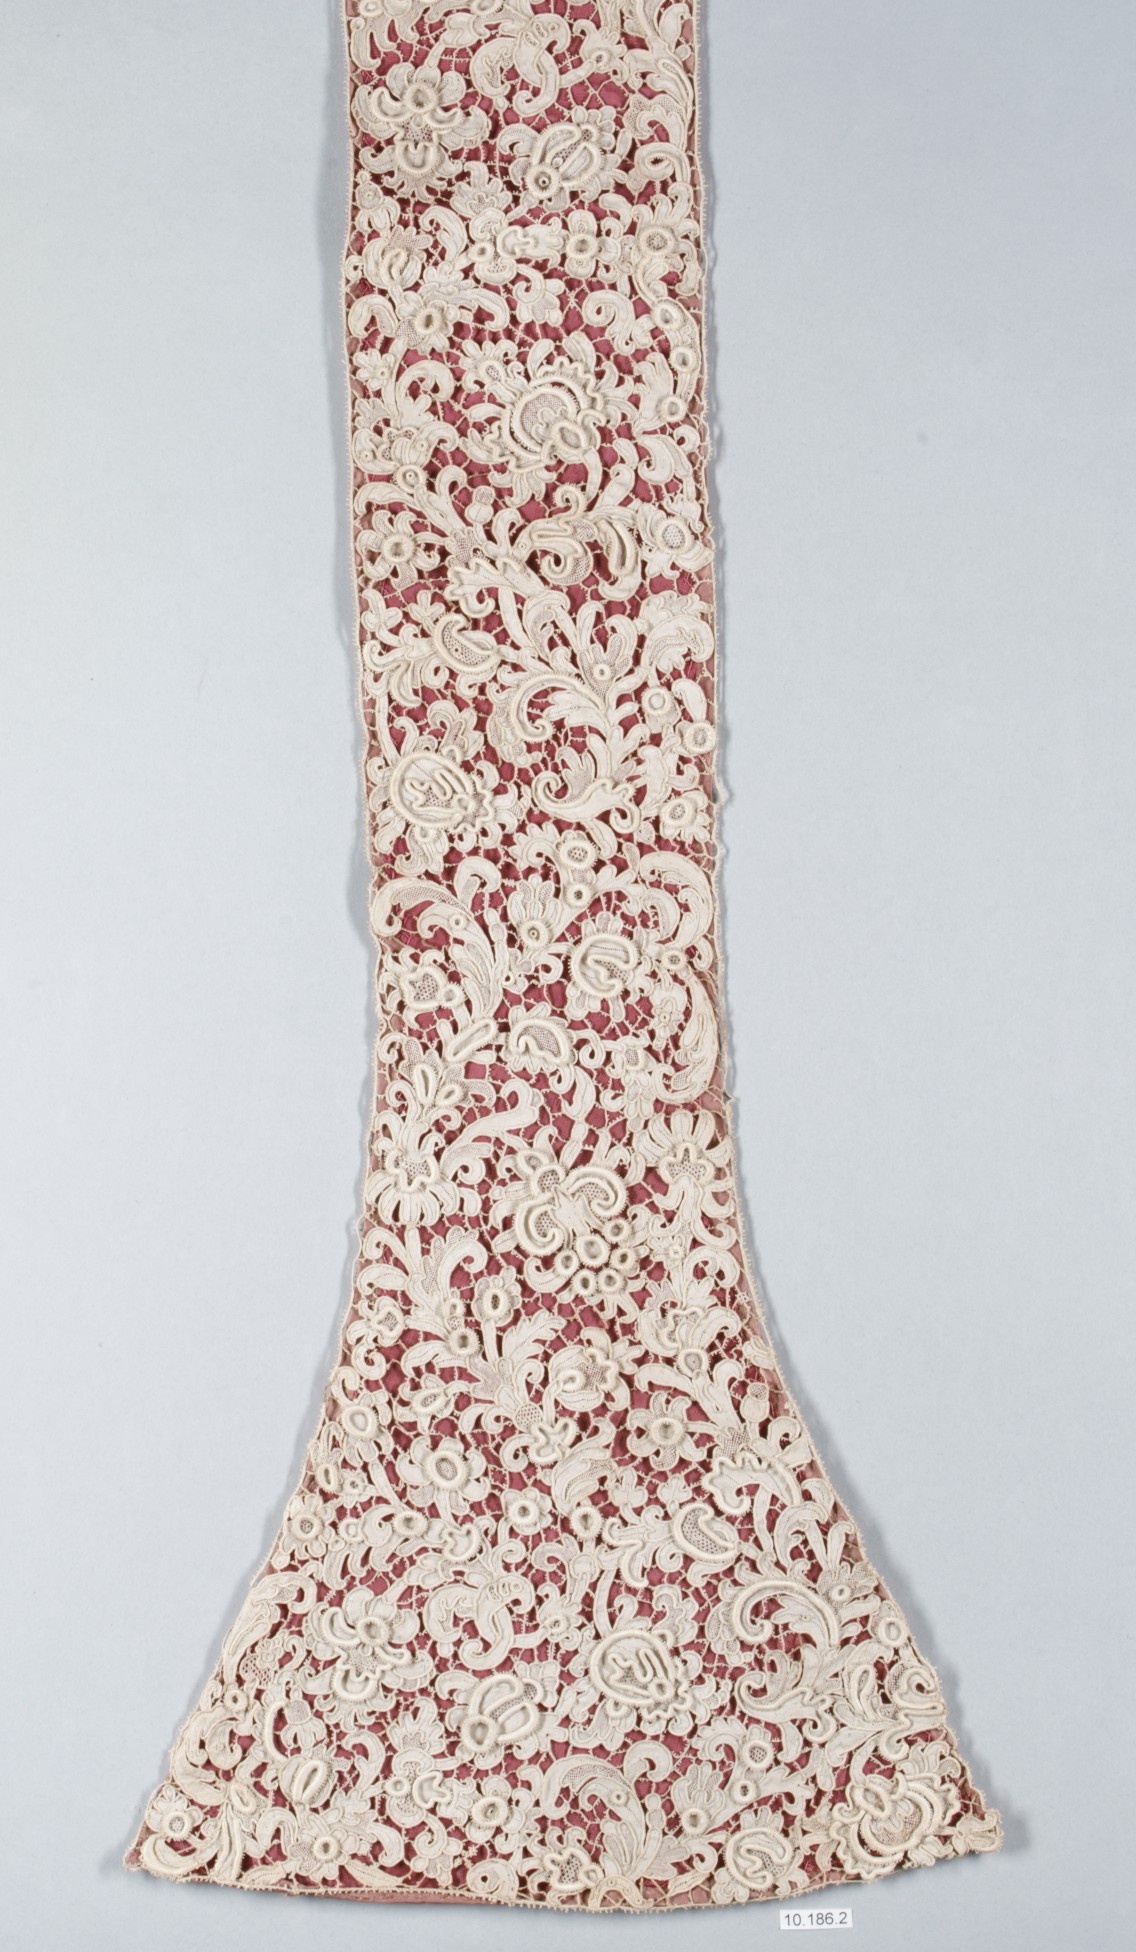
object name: maniple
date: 1651-1700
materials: lace, silk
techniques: gros point, lining, lace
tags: flowers